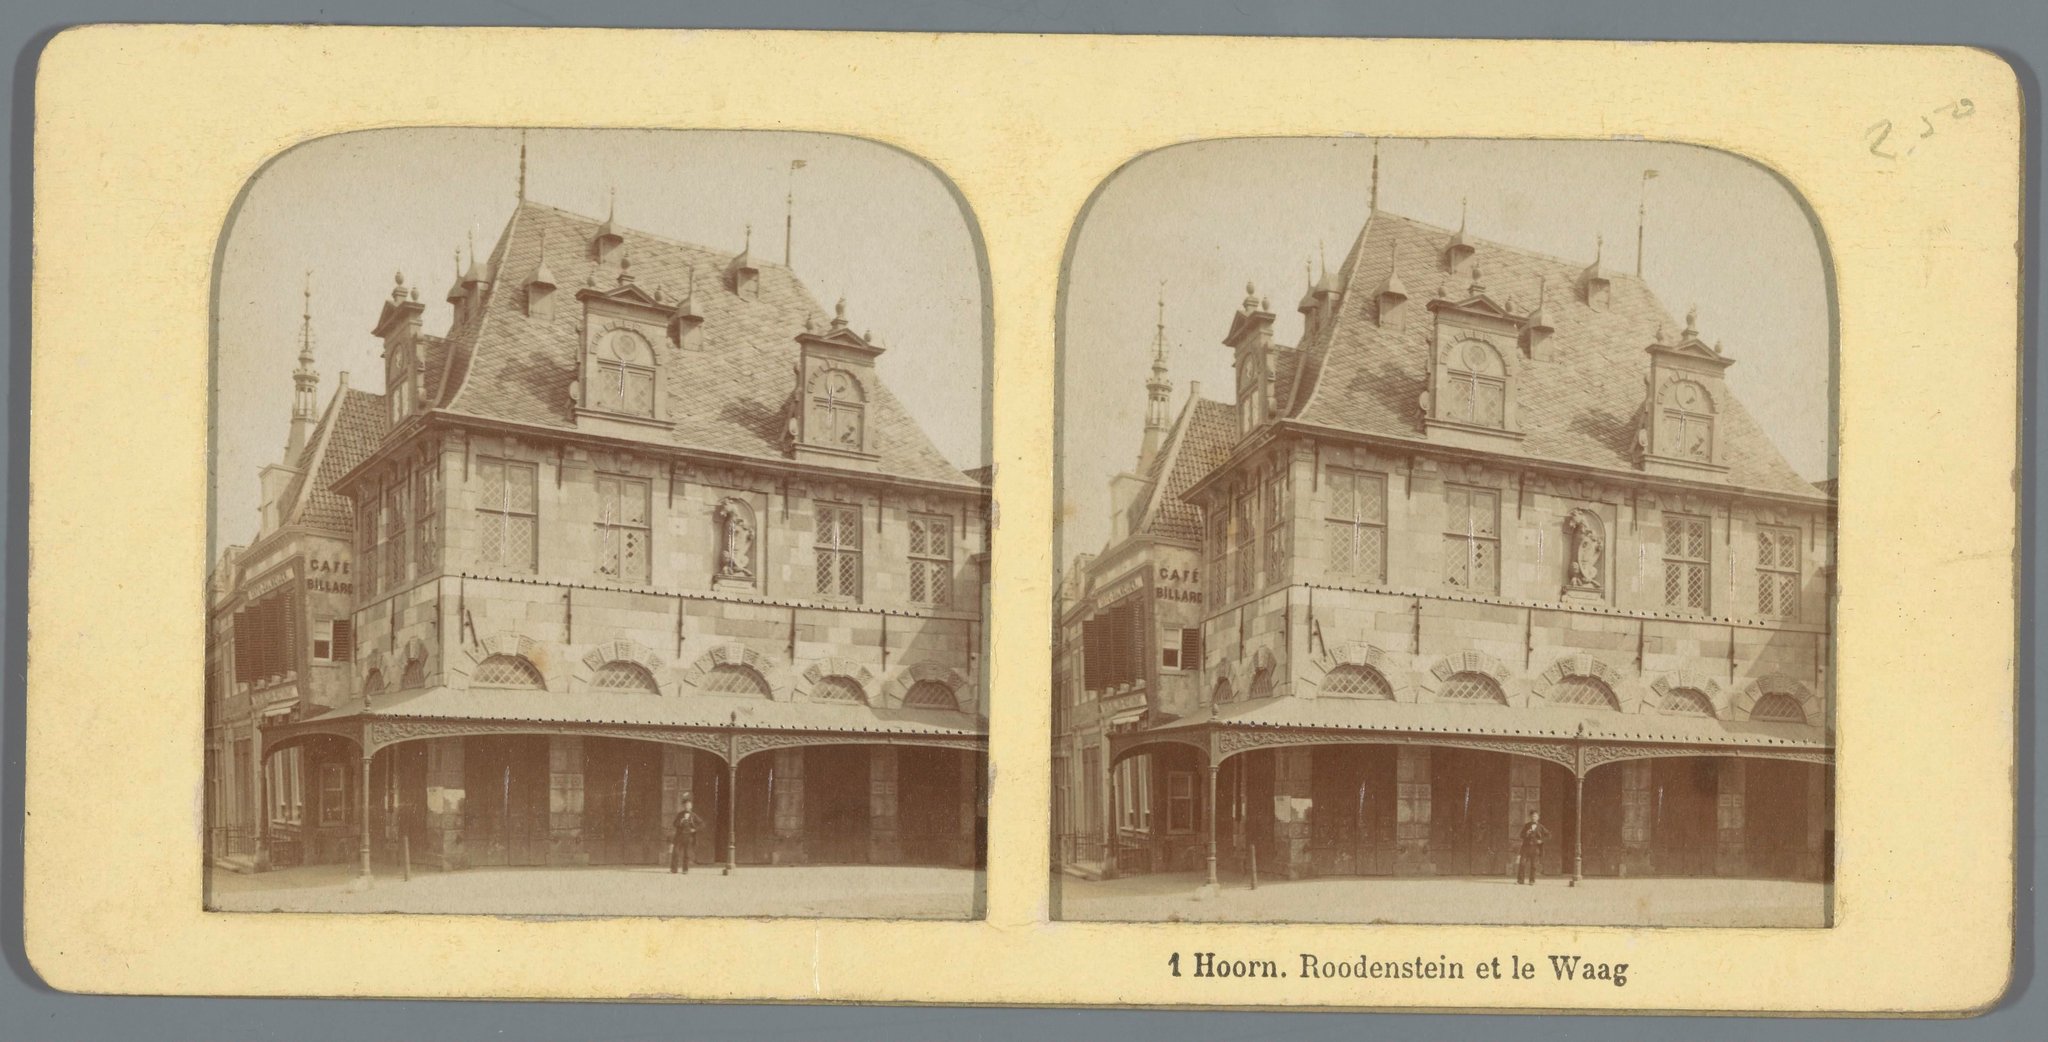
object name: tissue stereograph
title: Gezicht op de Waag in Hoorn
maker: Anonymous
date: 1855-1875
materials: cardboard, paper, photographic support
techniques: albumen print, cutting, hand coloring, perforating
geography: hoorn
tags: weigh-house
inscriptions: number: ‘9’, number: ‘1’